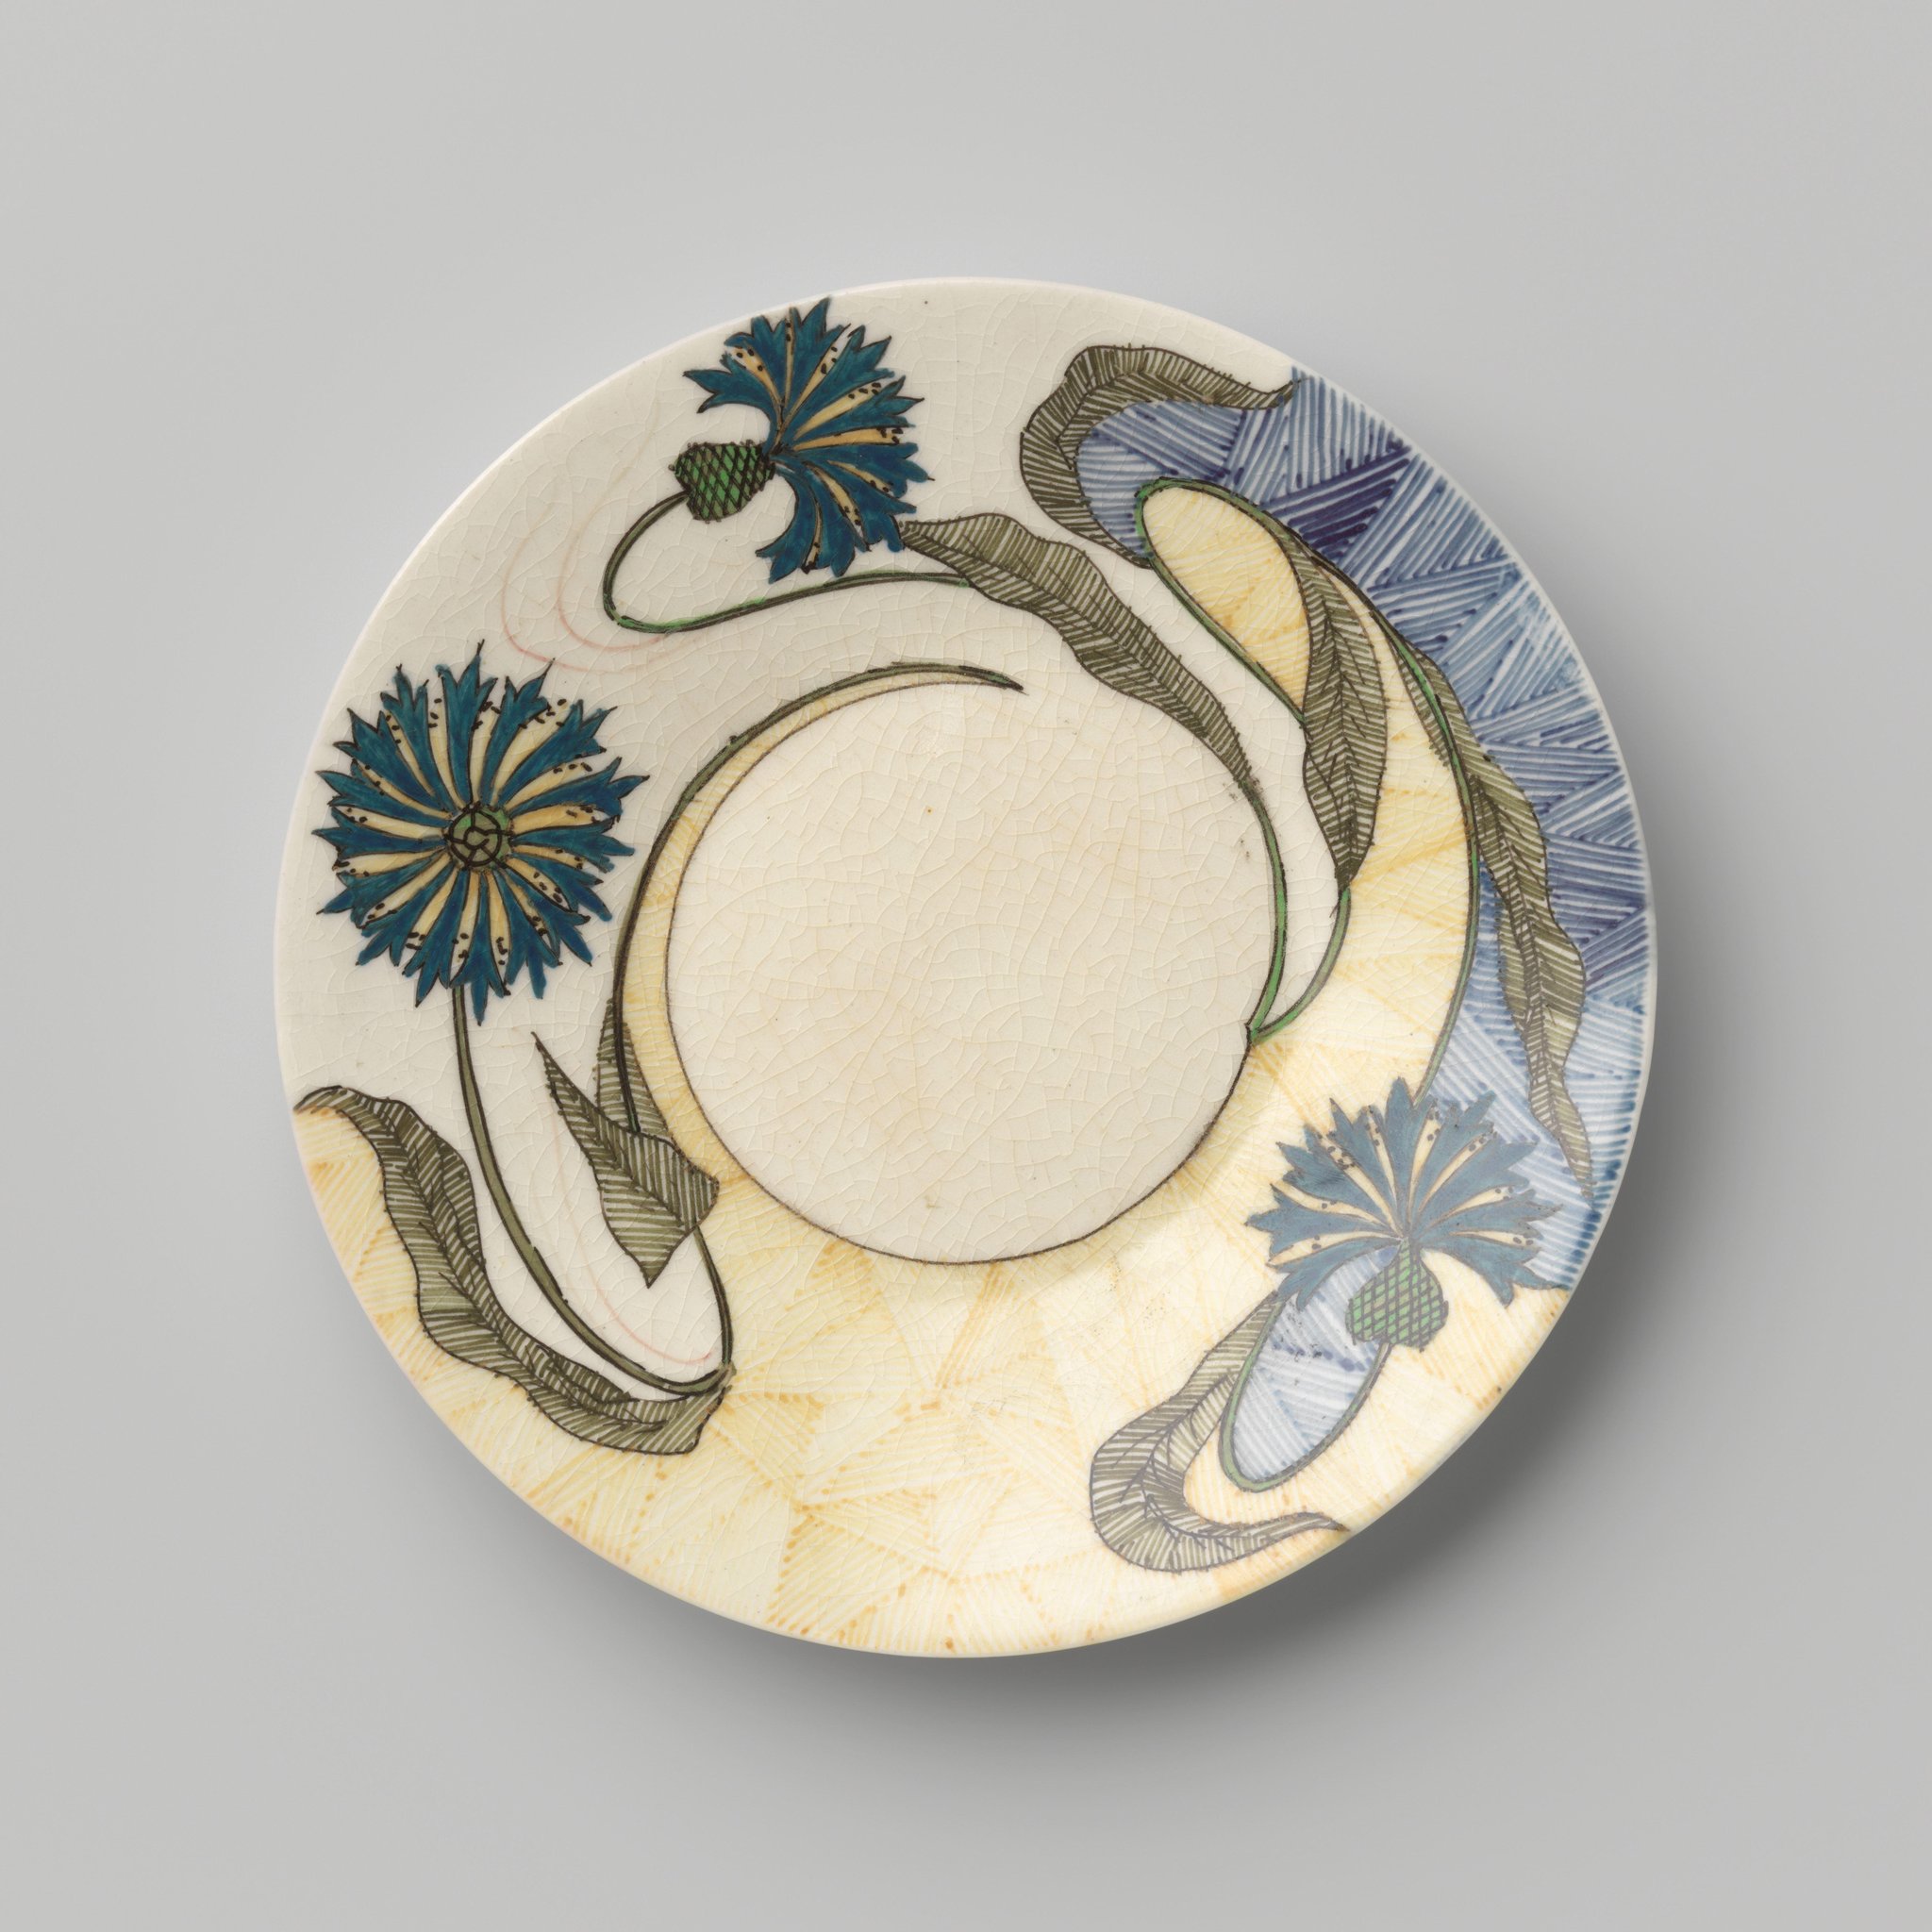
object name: platter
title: Schotel behorend bij kop, beschilderd met bloemen op een fond van gearceerde driehoeken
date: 1910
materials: earthenware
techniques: painted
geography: gouda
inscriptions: mark: ‘Made in // fabrieksmerk // Zuid.Holland ; p/a ; W.v.r. (alles in zwart) ; 5016 B (ingegrift)’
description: Schotel behorend bij een kop (A), van aardewerk. De schotel is polychroom beschilderd in de kleuren blauw, groen, geel, turkoois, grijsgroen en zwart met bloemen, deels op een gele fond van gearceerde driehoeken.